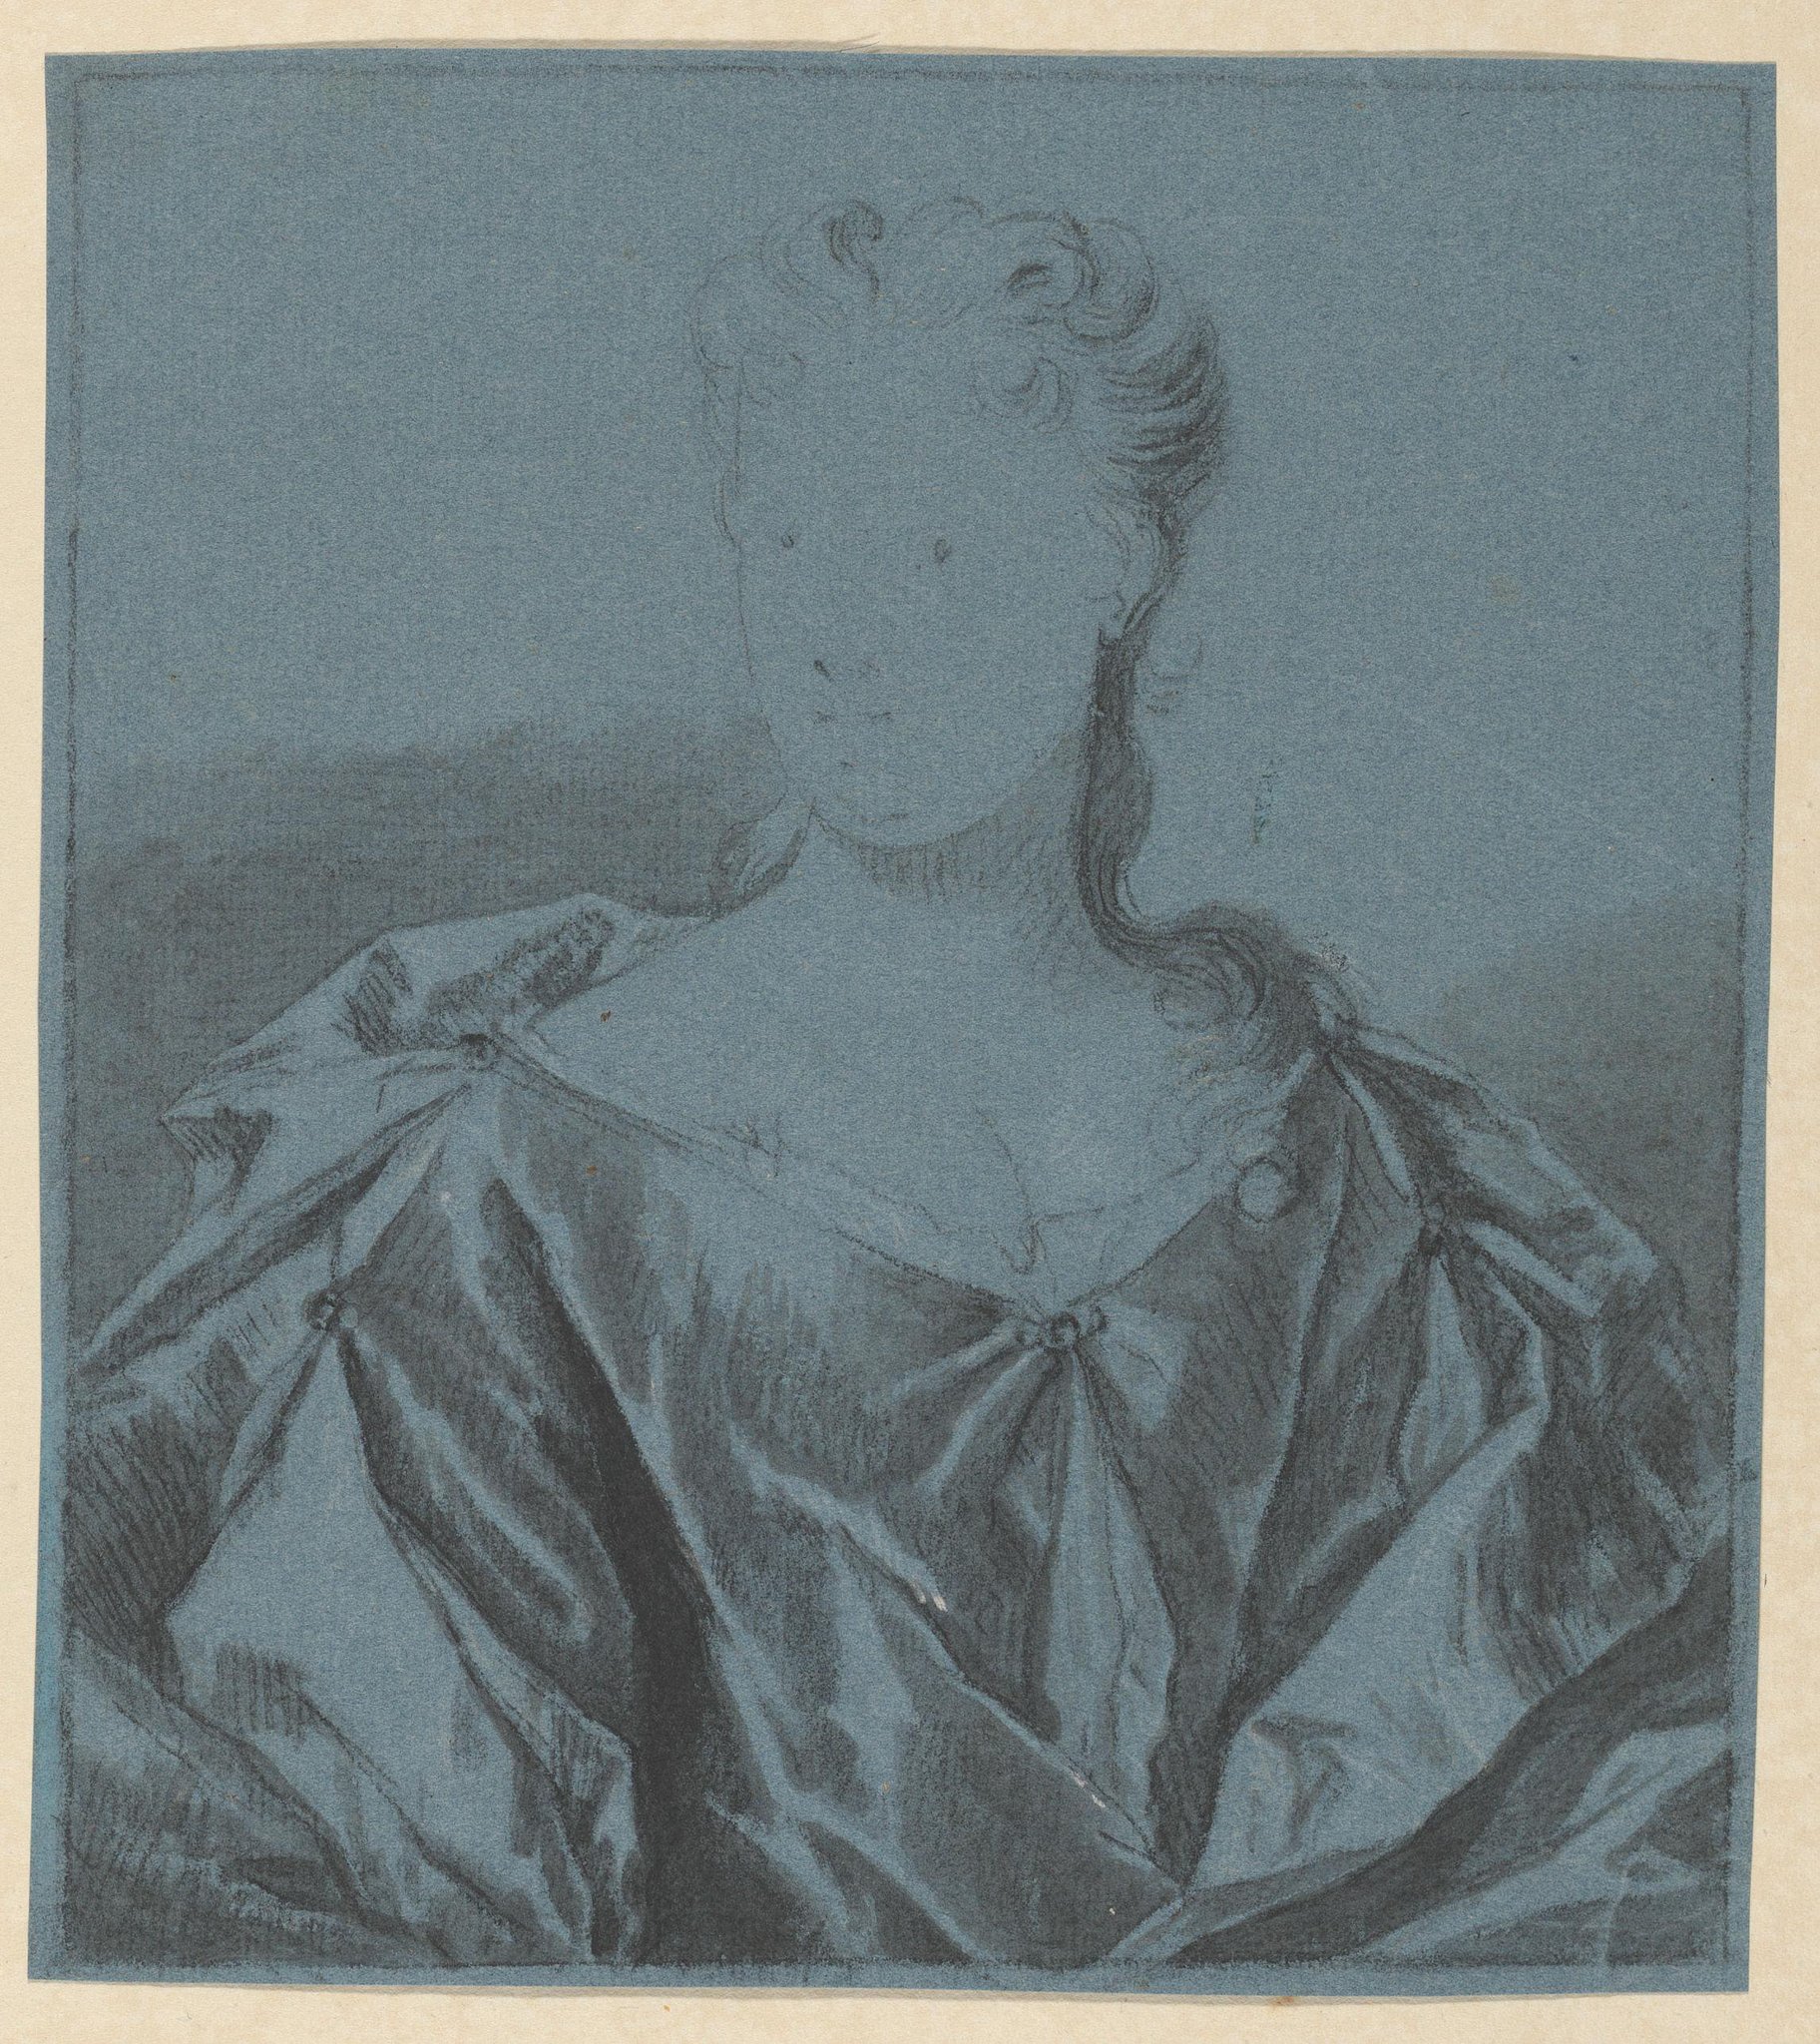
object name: album leaf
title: Portret van een vrouw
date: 1649-1723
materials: chalk, paper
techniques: pasting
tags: historical persons not known by name - bb - woman, wig